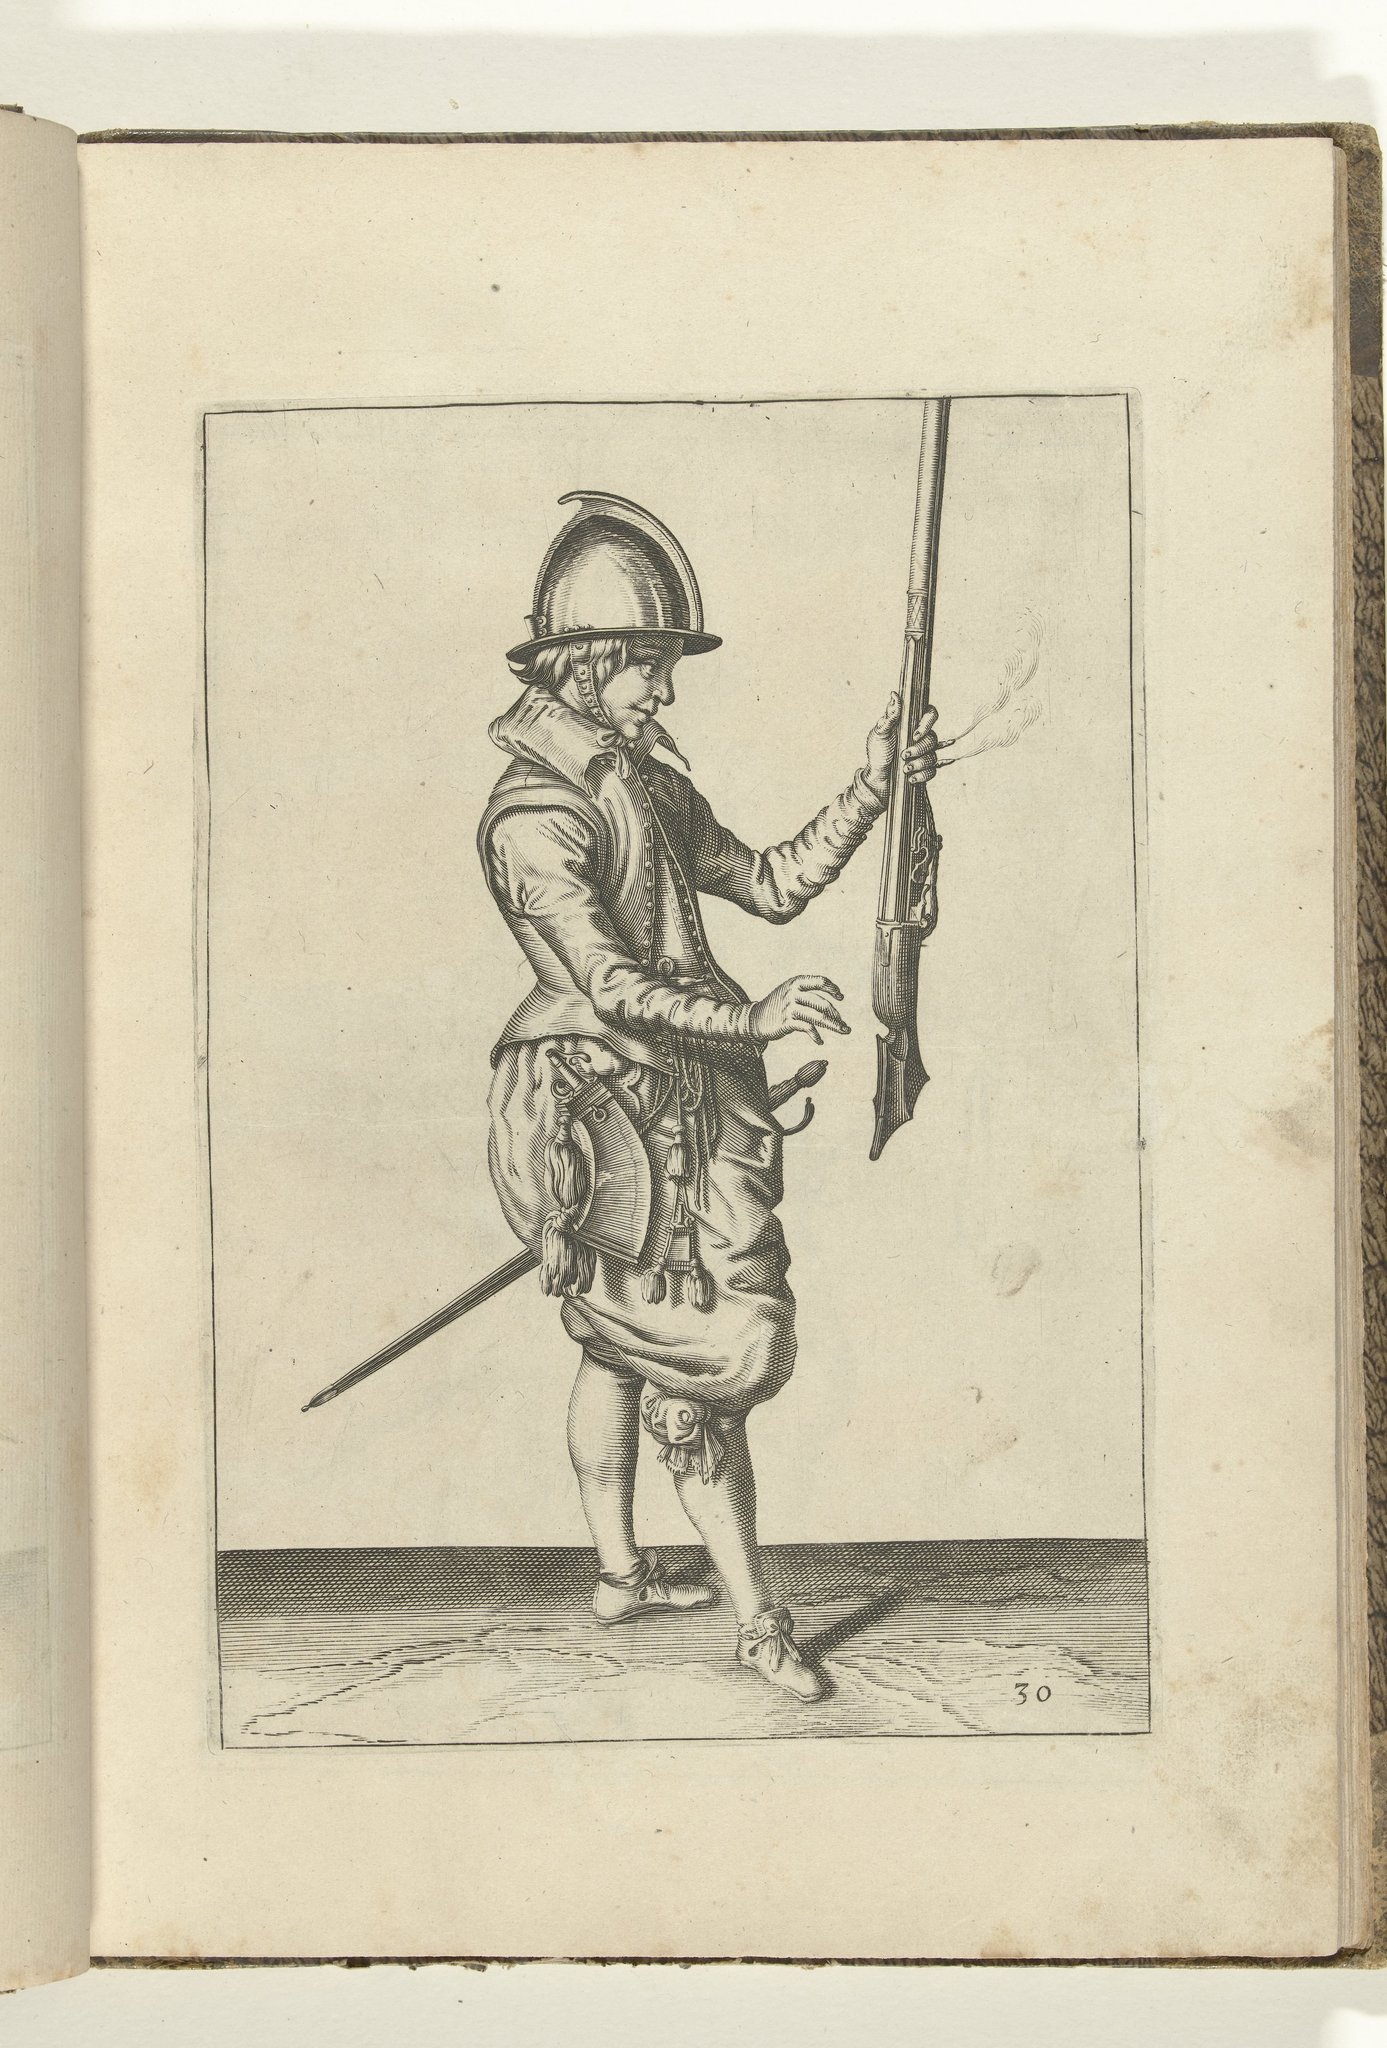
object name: print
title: Soldaat die zijn roer met zijn linkerhand rechtop vasthoudt (nr. 30), ca. 1600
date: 1597-1608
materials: paper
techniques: engraving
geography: northern netherlands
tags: maurice (prince of orange), handling of weapons ~ military training, weapons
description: Een soldaat, ten voeten uit, naar rechts, die een roer (een bepaald type vuurwapen) met zijn linkerhand vasthoudt, de loop omhoog wijzend, alvorens het wapen over te brengen naar zijn rechterhand. In zijn linkerhand behalve het roer ook een brandende lont (nr. 30), ca. 1600. Plaat 30 in de instructies voor het hanteren van de roer: Brief enseignement, sur la representation des figures, du droit maniement de l'Harquebuse. Onderdeel van de illustraties in een Franse editie van J. de Gheyns Wapenhandelinghe: J. de Gheyn, Maniement d'armes, d'arquebuses, mousquetz et piques : en conformité de l'ordre de Mour le Prince Maurice, Prince d'Orange, Amsterdam 1608. Krijgswezen rond 1600.